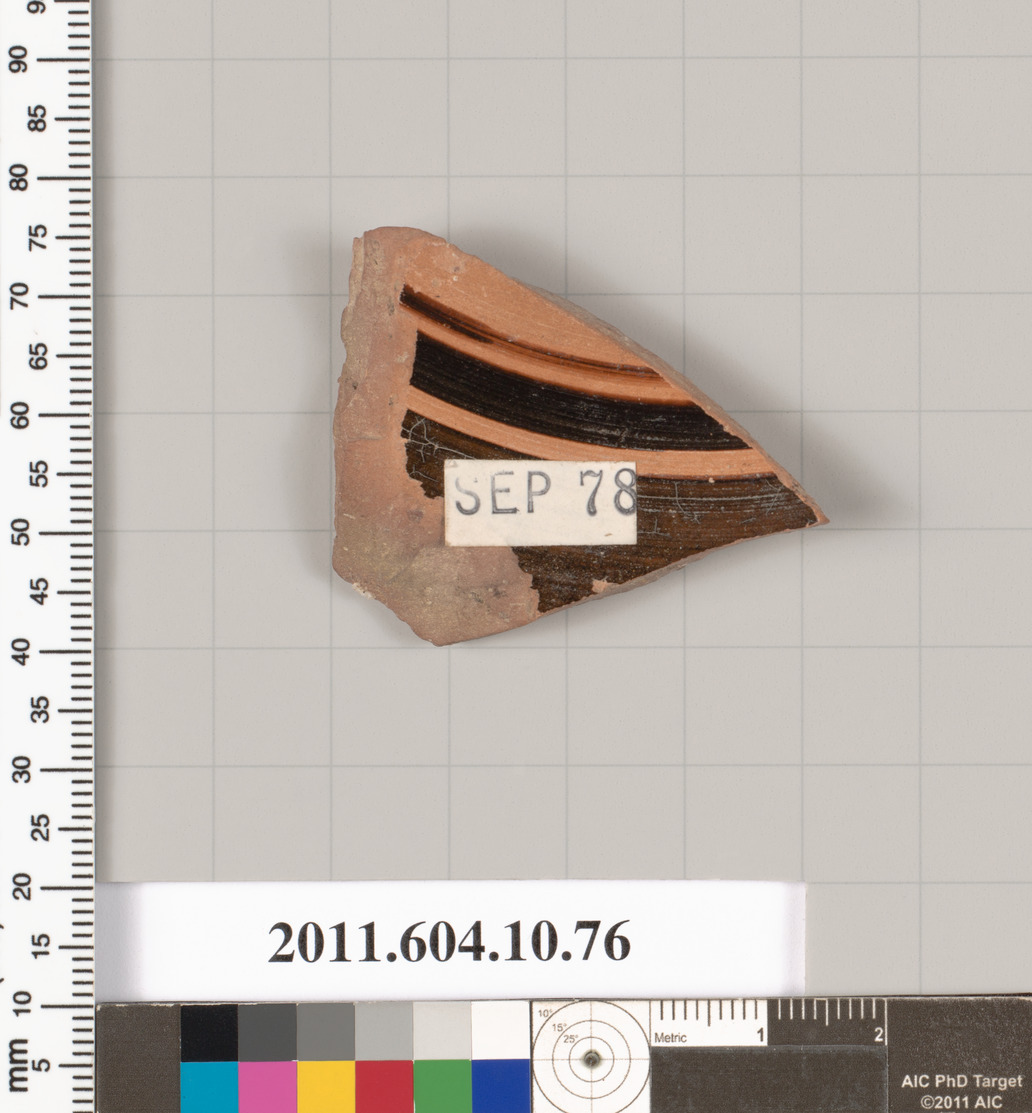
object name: fragment of a bowl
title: Terracotta fragment of a bowl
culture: etruscan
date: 400-301 BCE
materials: terracotta